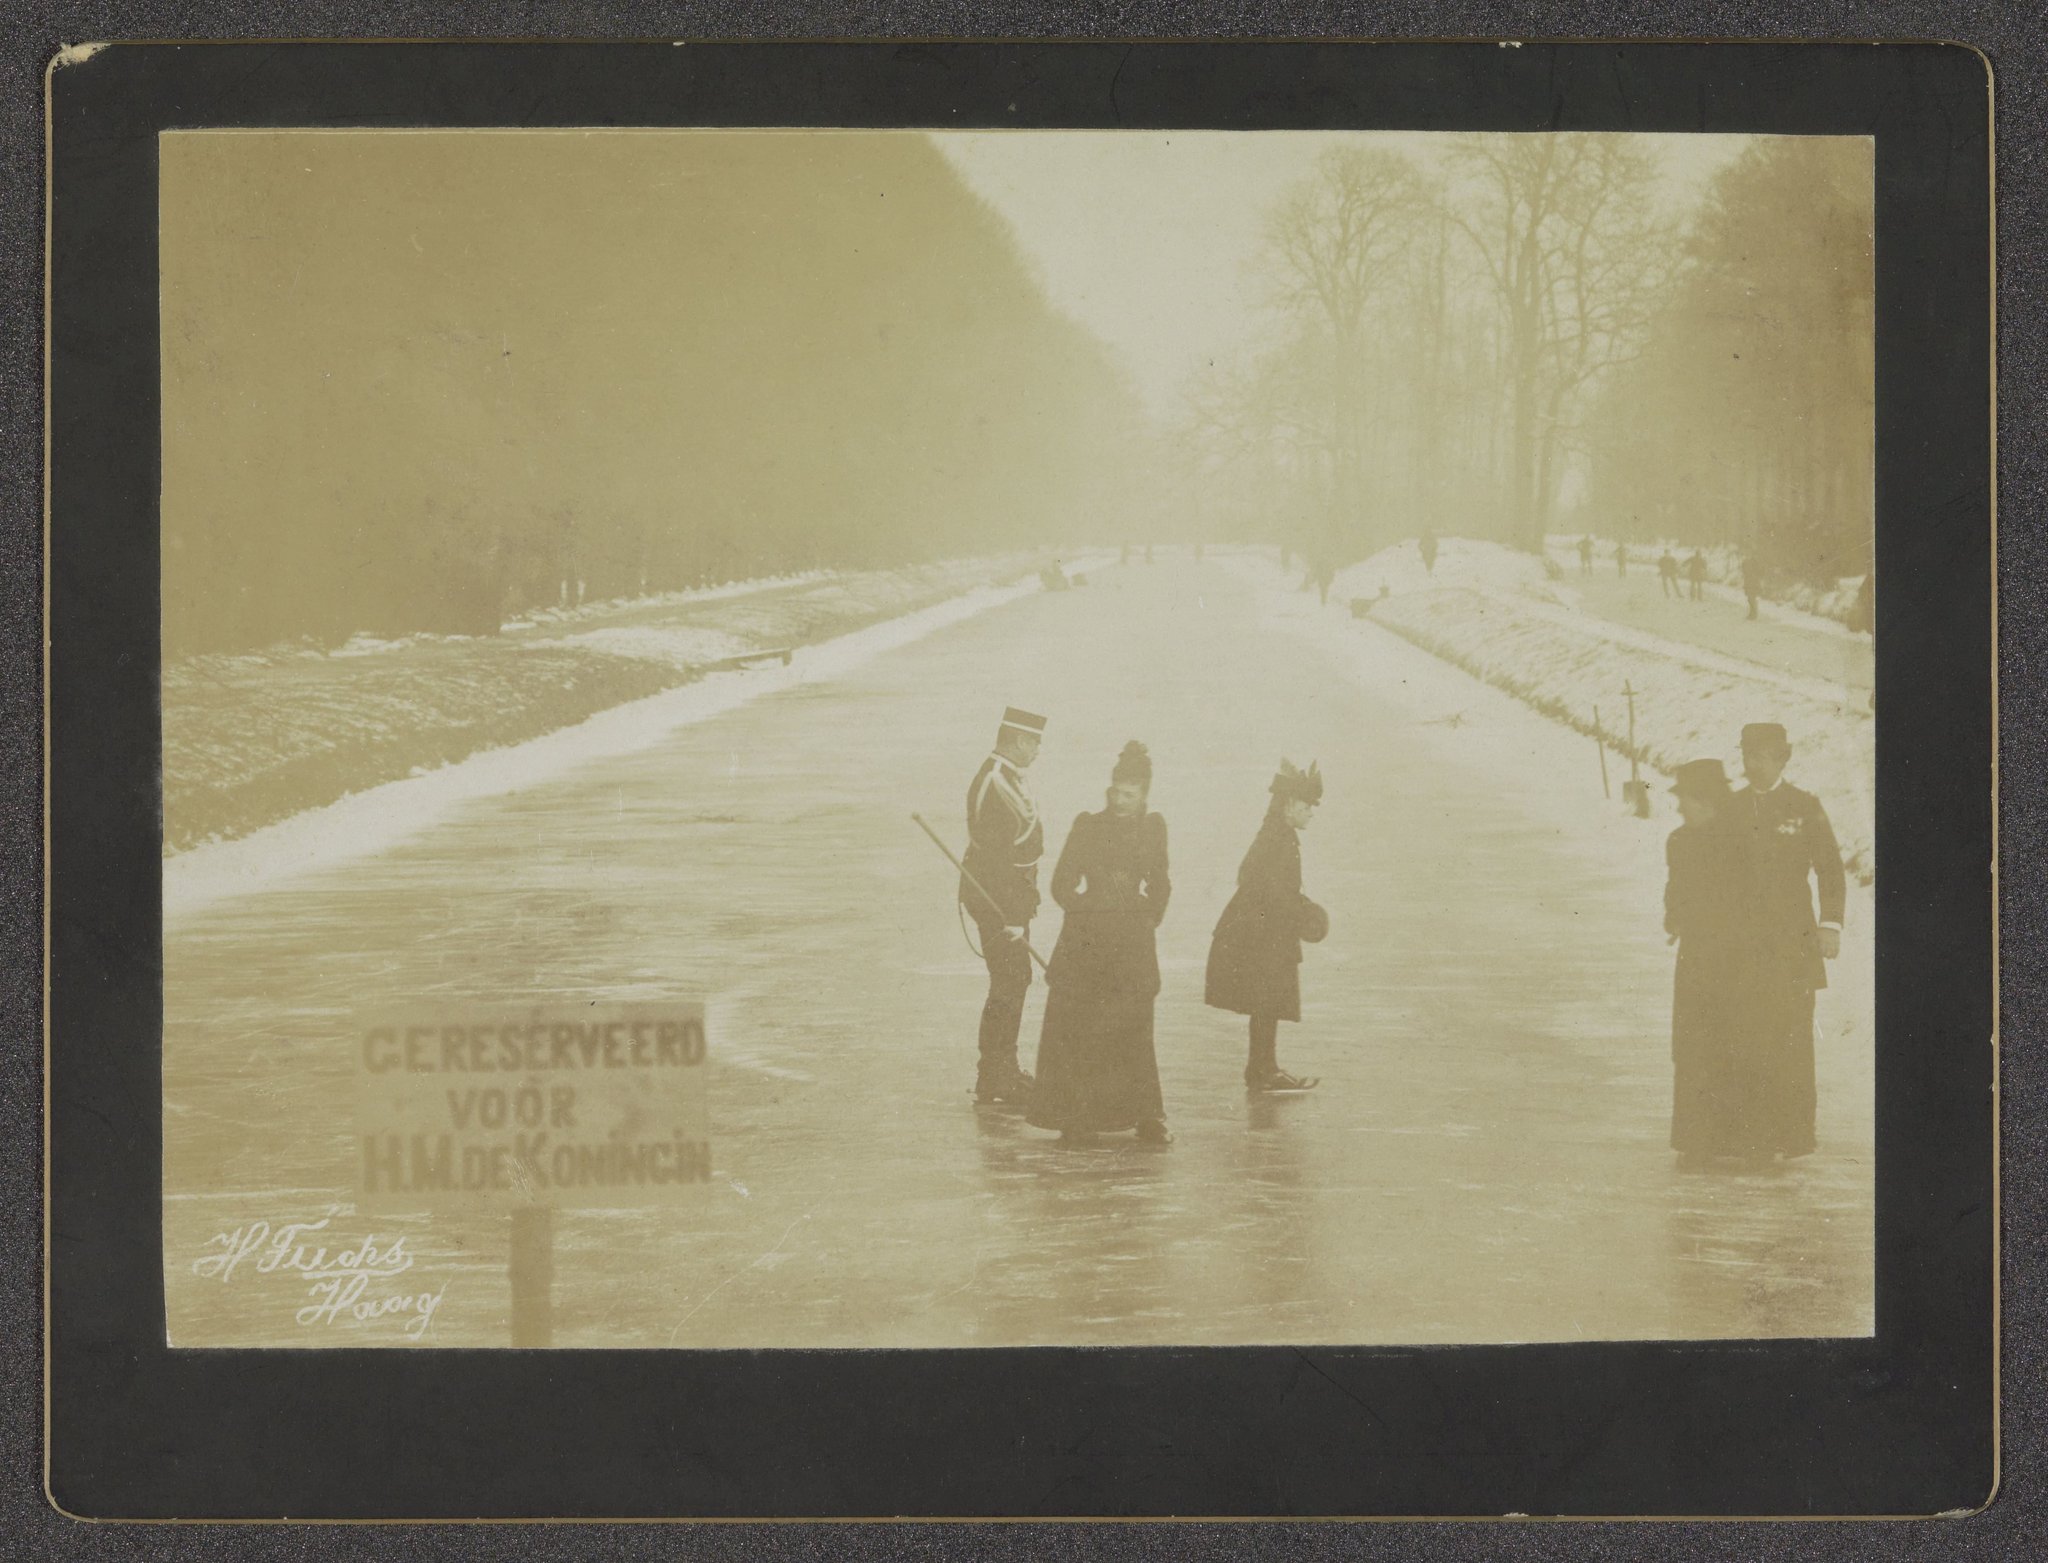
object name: photograph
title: Wilhelmina als kind op schaatsen op een bevroren vijver 'Gereserveerd voor H.M. de Koningin'.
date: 1893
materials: cardboard, paper, photographic support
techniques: gelatin silver print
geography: the hague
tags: the hague, print maker, wilhelmina of the netherlands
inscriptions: date: ‘1e helft januari 1893’, signature: ‘H. Fuchs Haag’, label: ‘M.M. Couvée 's-Gravenhage, Lange Poten 41’